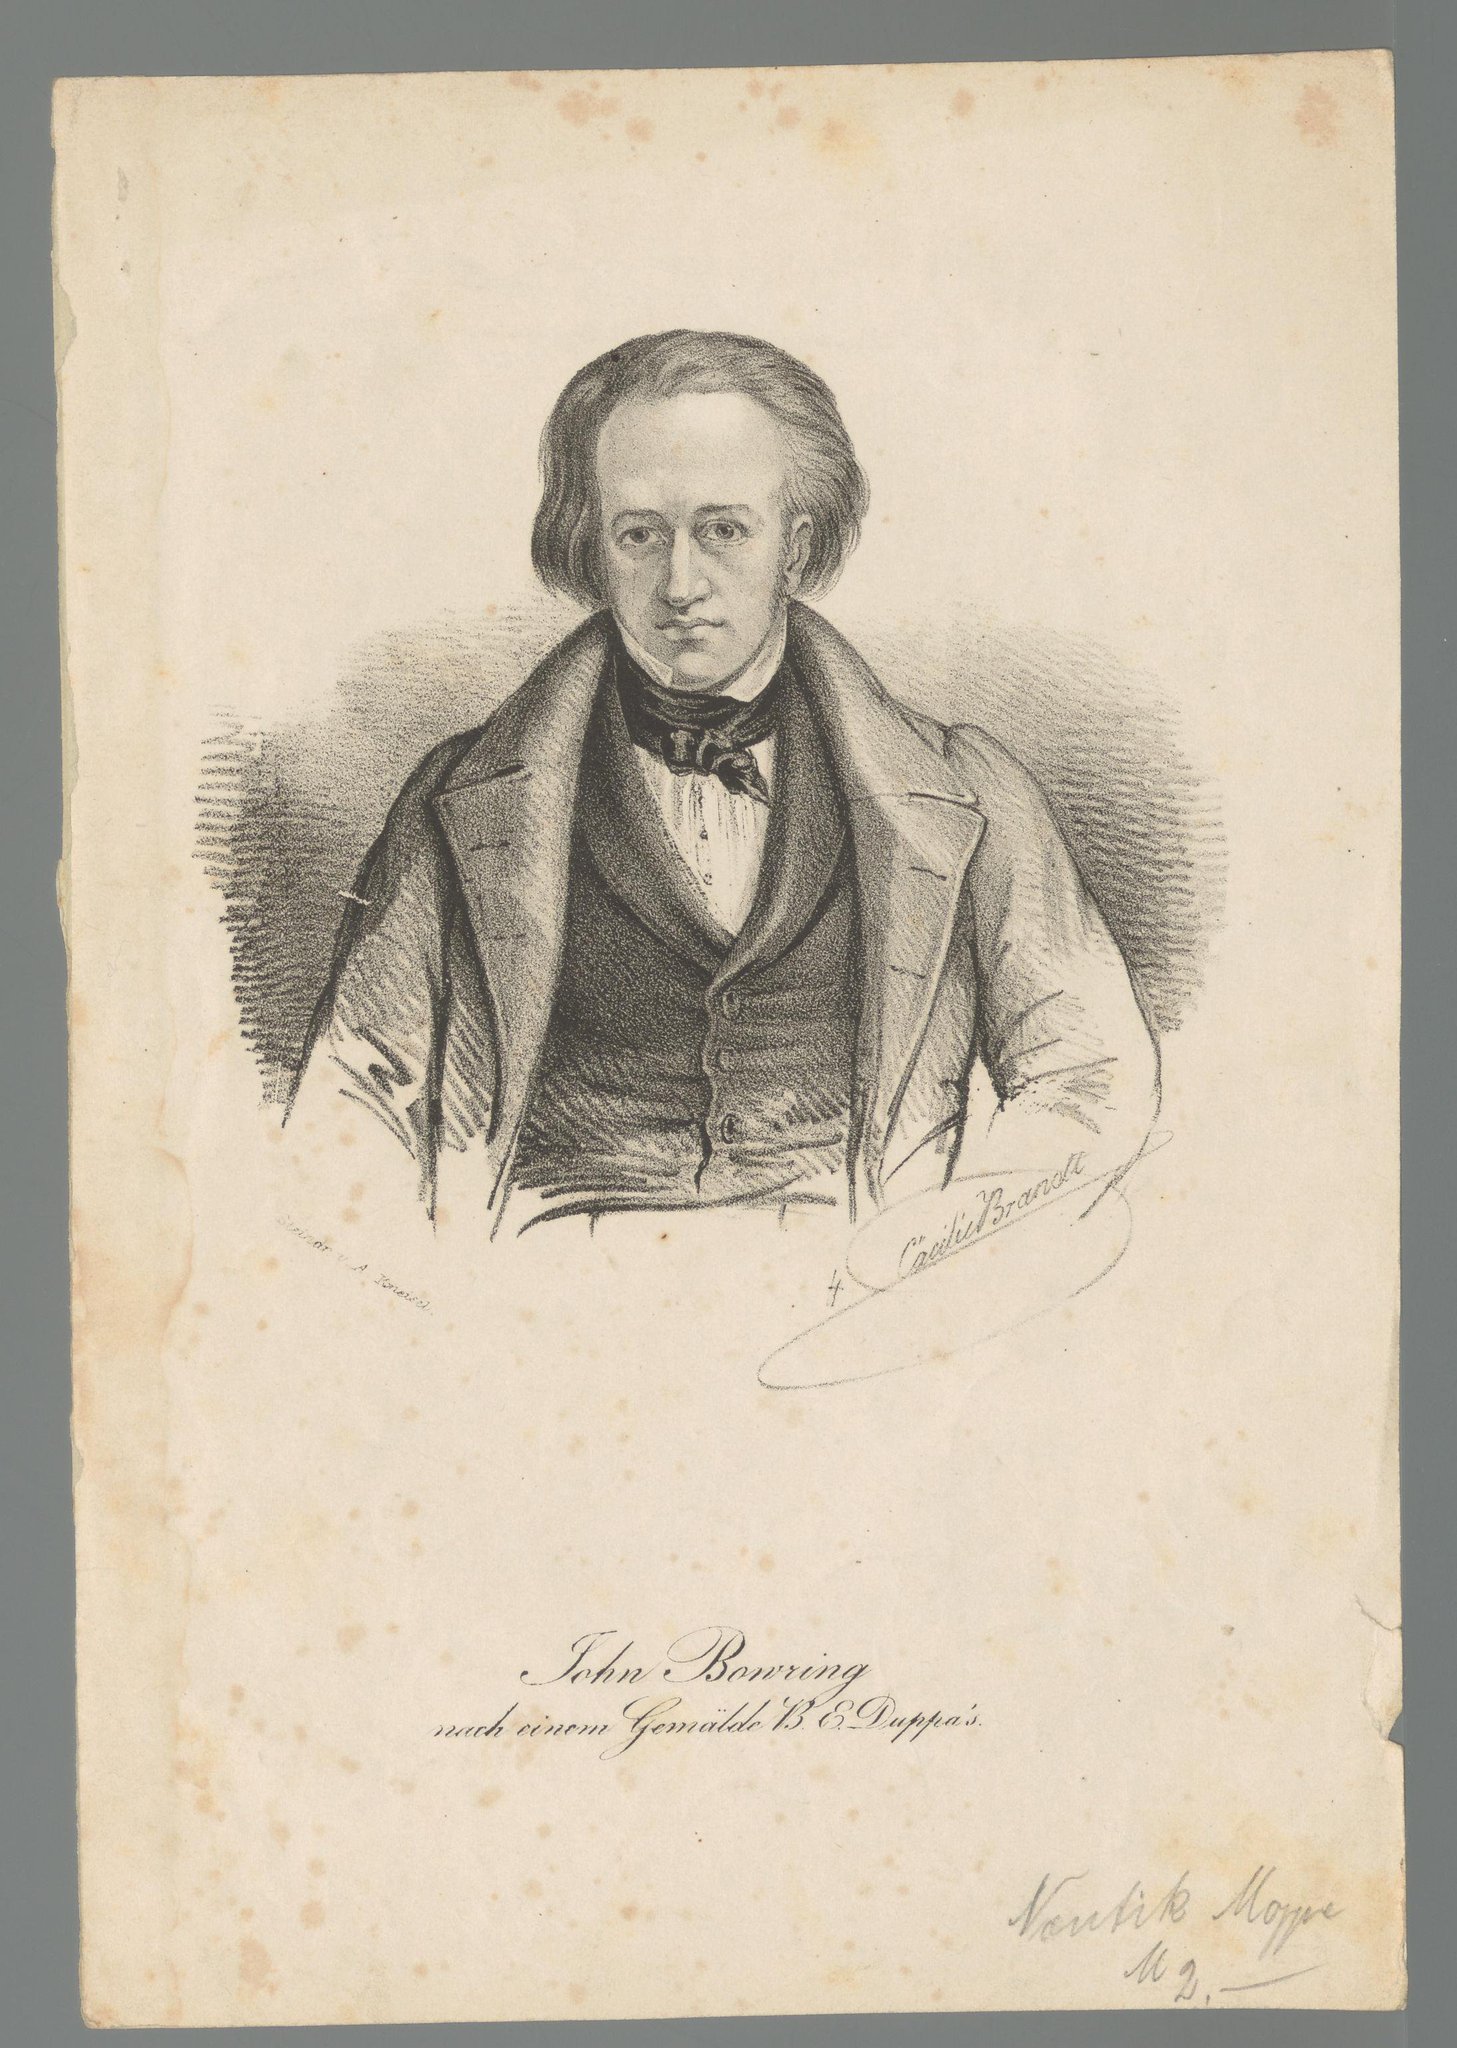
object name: print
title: John Bowring nach einem Gemälde B.E. Duppa's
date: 1829-1839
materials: paper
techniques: lithograph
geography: leipzig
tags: adult man, historical persons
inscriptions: collector's mark: Lugt 2228, inscription: ‘Portr. 60817/ Bowring LB XXIV 443242’, collector's mark: Lugt 2760